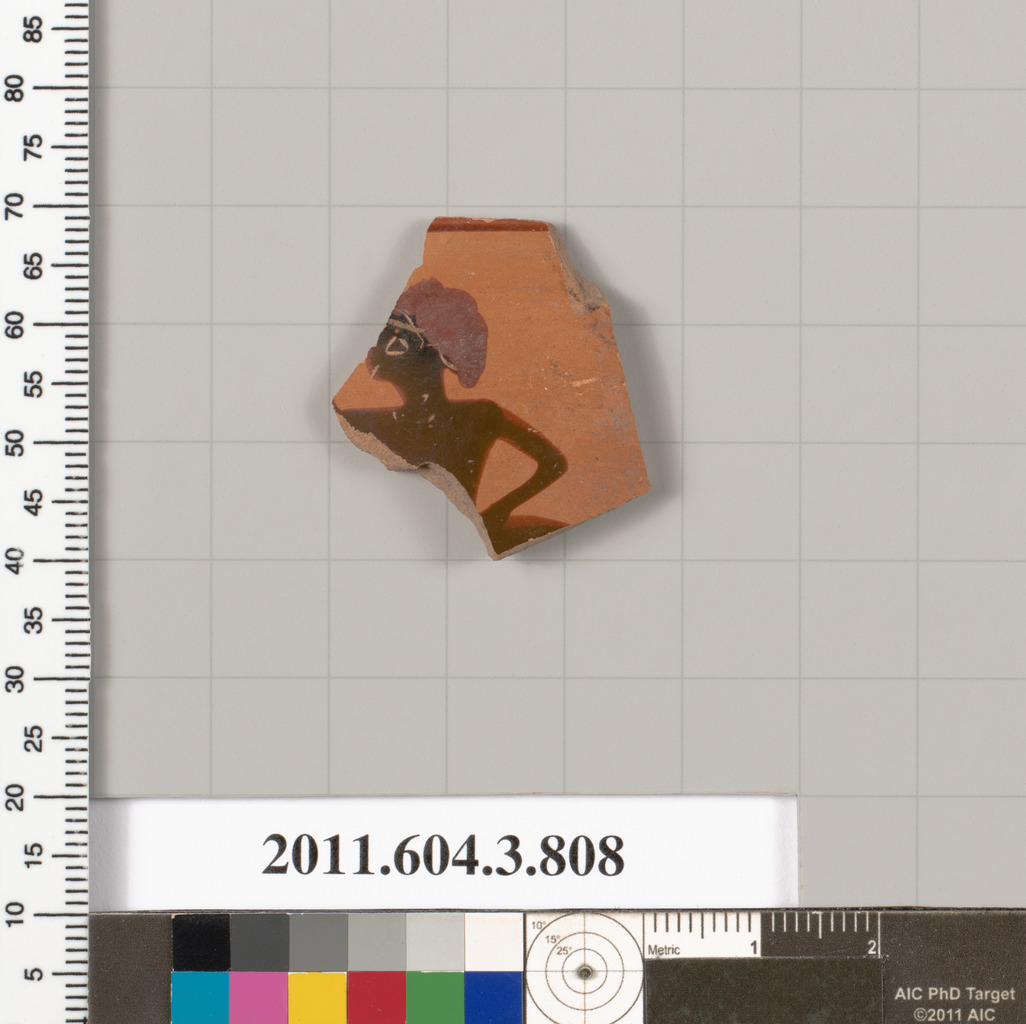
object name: lekythos fragment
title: Terracotta fragment of a lekythos (oil flask)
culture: greek, attic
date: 550-526 BCE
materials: terracotta